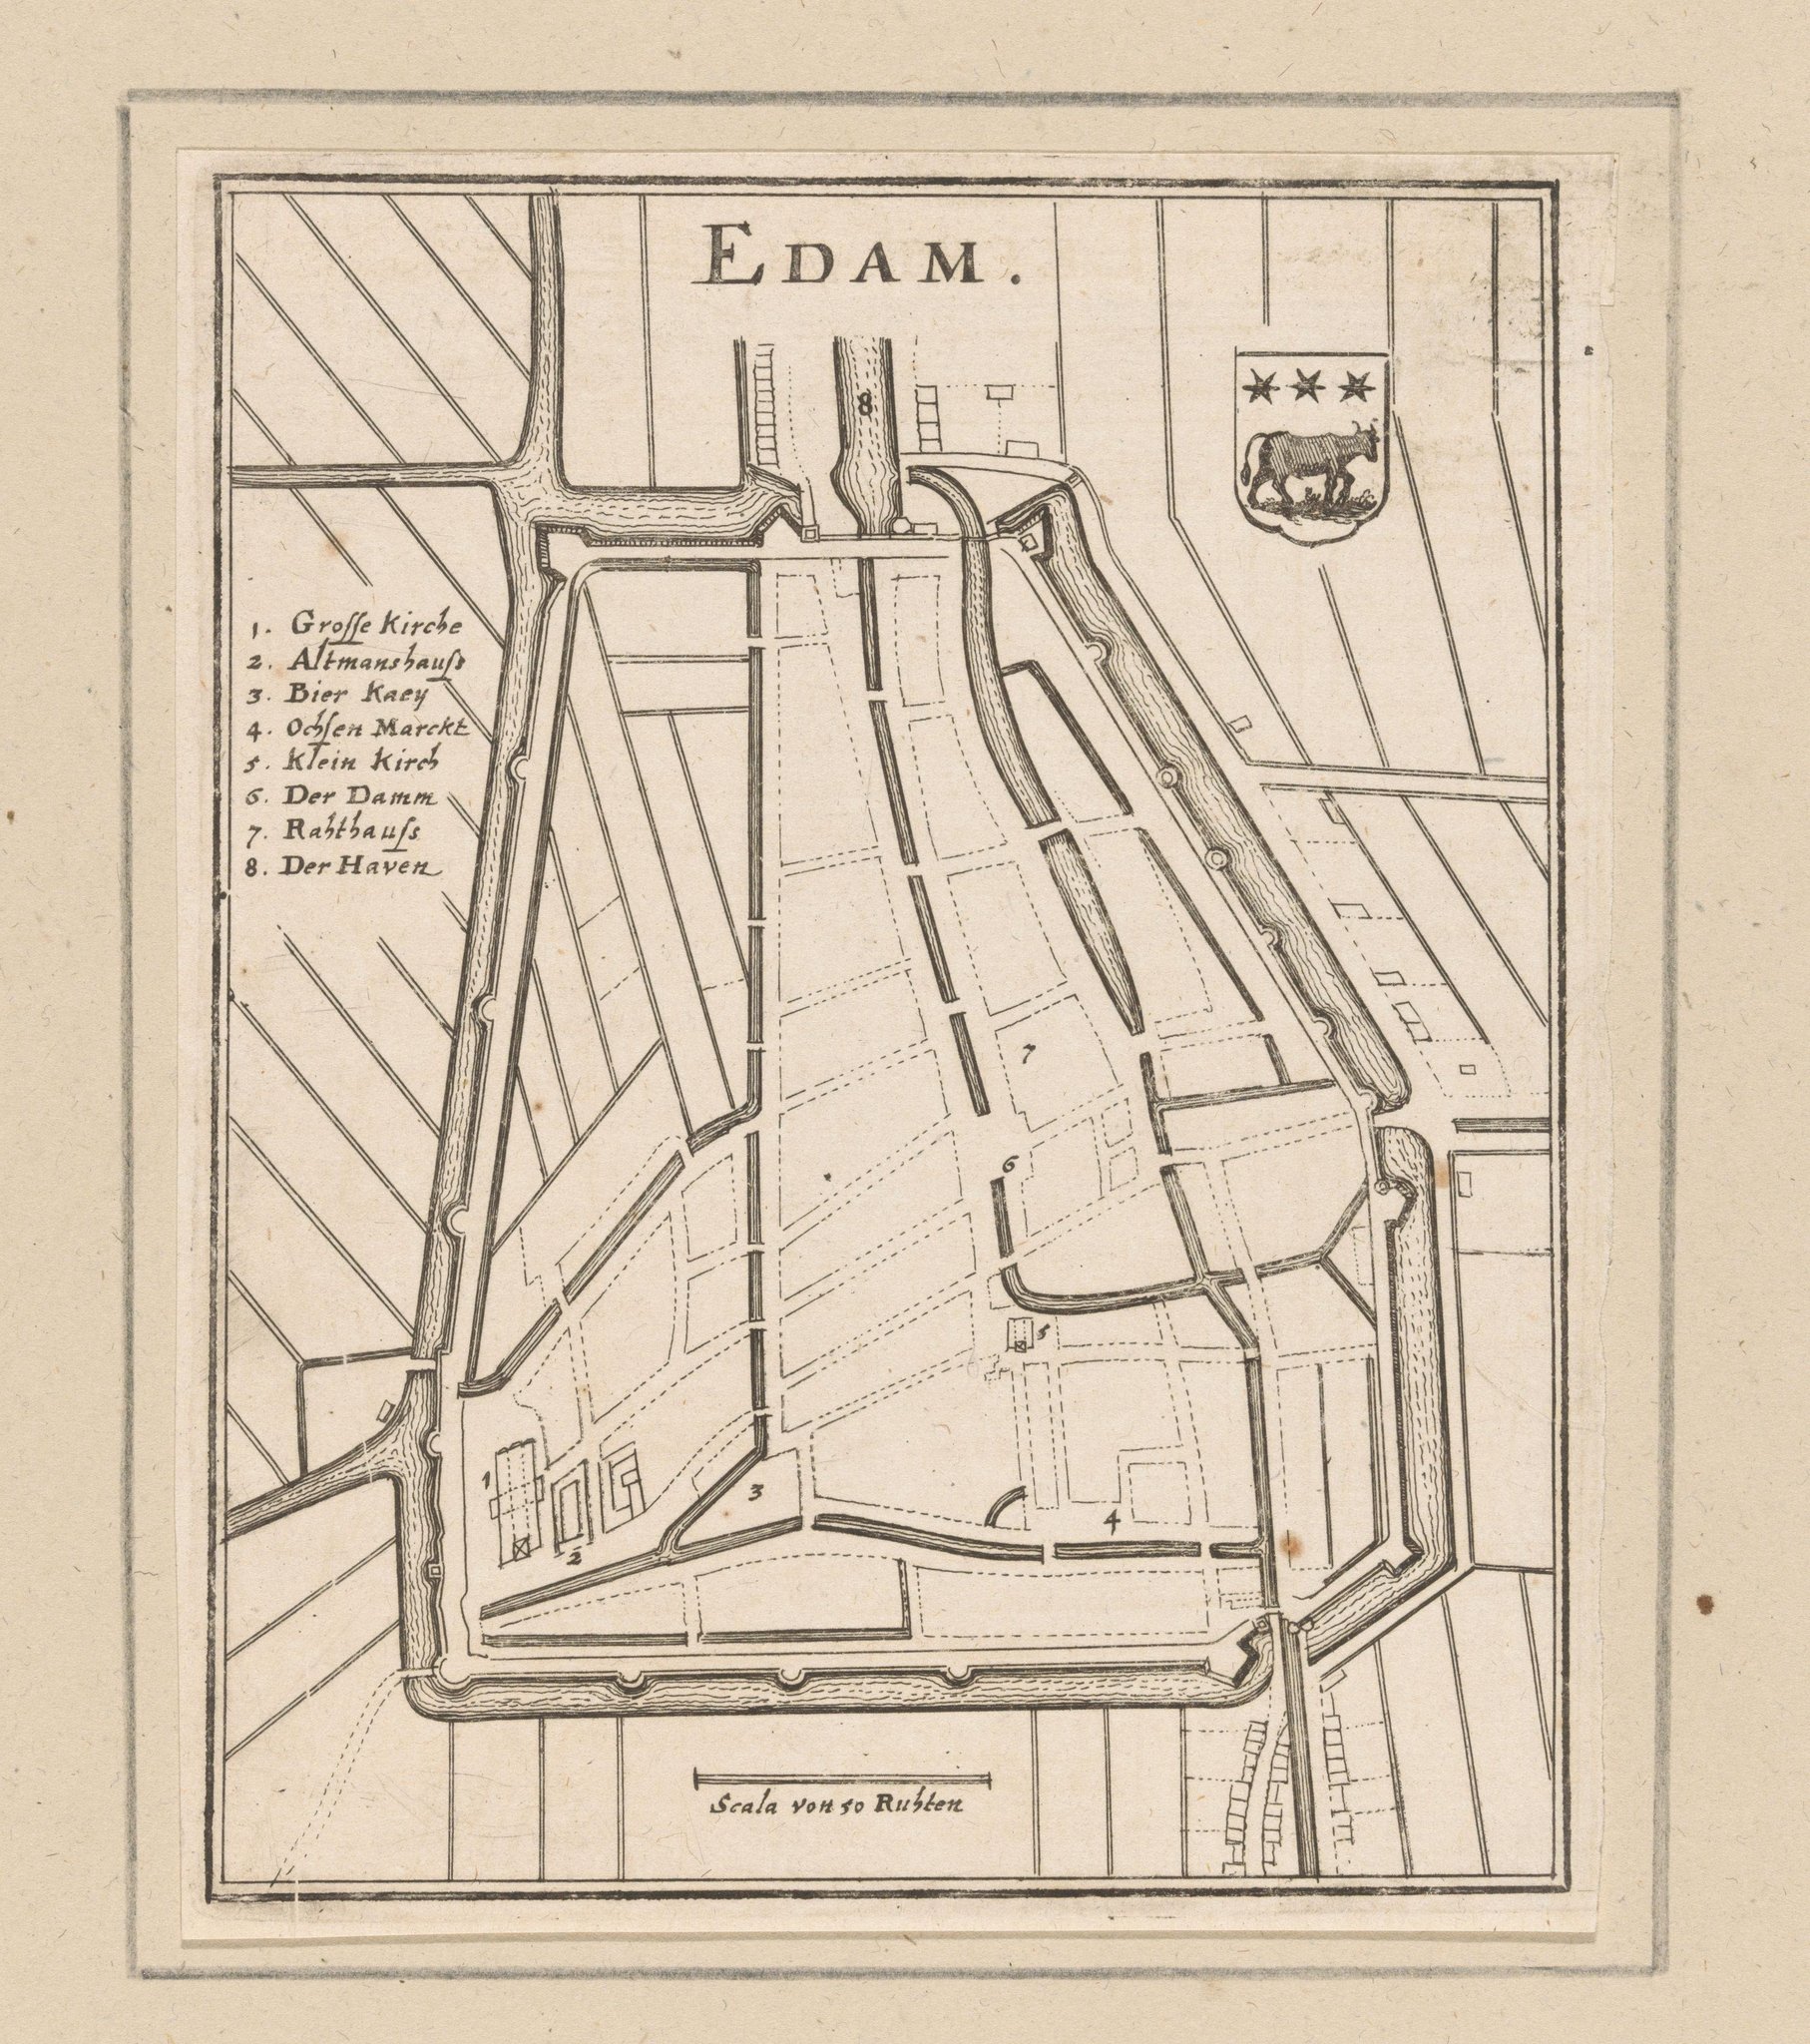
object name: area plan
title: Vestingplattegrond van Edam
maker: caspar merian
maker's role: print maker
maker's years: 1627-1689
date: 1654-1700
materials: paper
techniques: etching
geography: frankfurt am main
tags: coat of arms (as symbol of the state, etc.) (+ city; municipal), fortified city, maps of cities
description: Prent gebruikt in: Zeiller, Martin. M.Z. Topographia Circuli Burgundici Oder Beschreibung une Eigentliche Abbildung der Vornehmsten Örter in dem Hochlöblichen Burgund- un Niderlandischen Crayse. Frankfurt am Main: Caspar Merian, 1654. Of in: Zeiller, Martin. M. Z. Topographia Germaniae-Inferioris vel Circuli-Burgundici, das ist Beschreibung (…). Frankfurt am Main: Caspar Merian, 1659. Of in een van de twee latere uitgaven van deze publicatie die, hoewel het jaar 1659 erin staat vermeld als jaar van uitgave, zijn uitgegeven in respectievelijk ca. 1670 en ca. 1700.